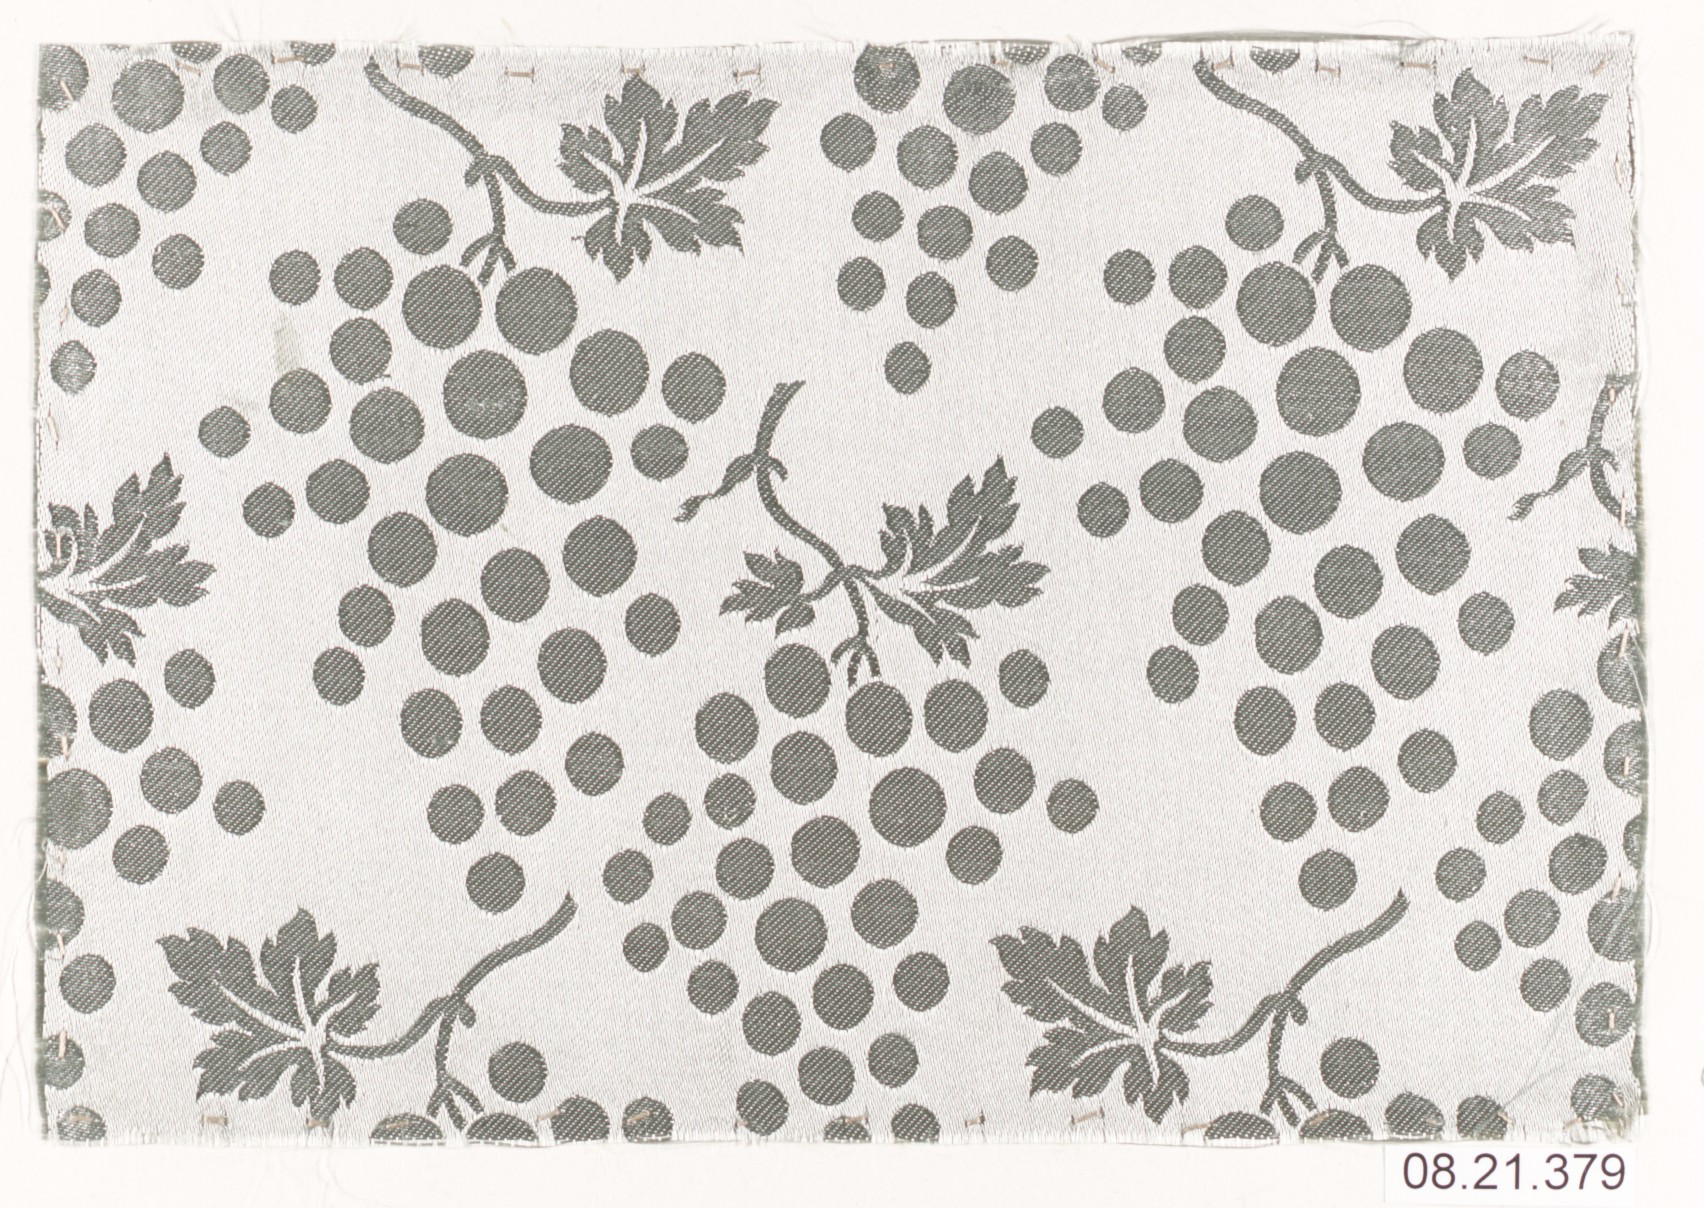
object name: textile sample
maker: Anonymous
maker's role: designer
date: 1900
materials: silk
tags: leaves